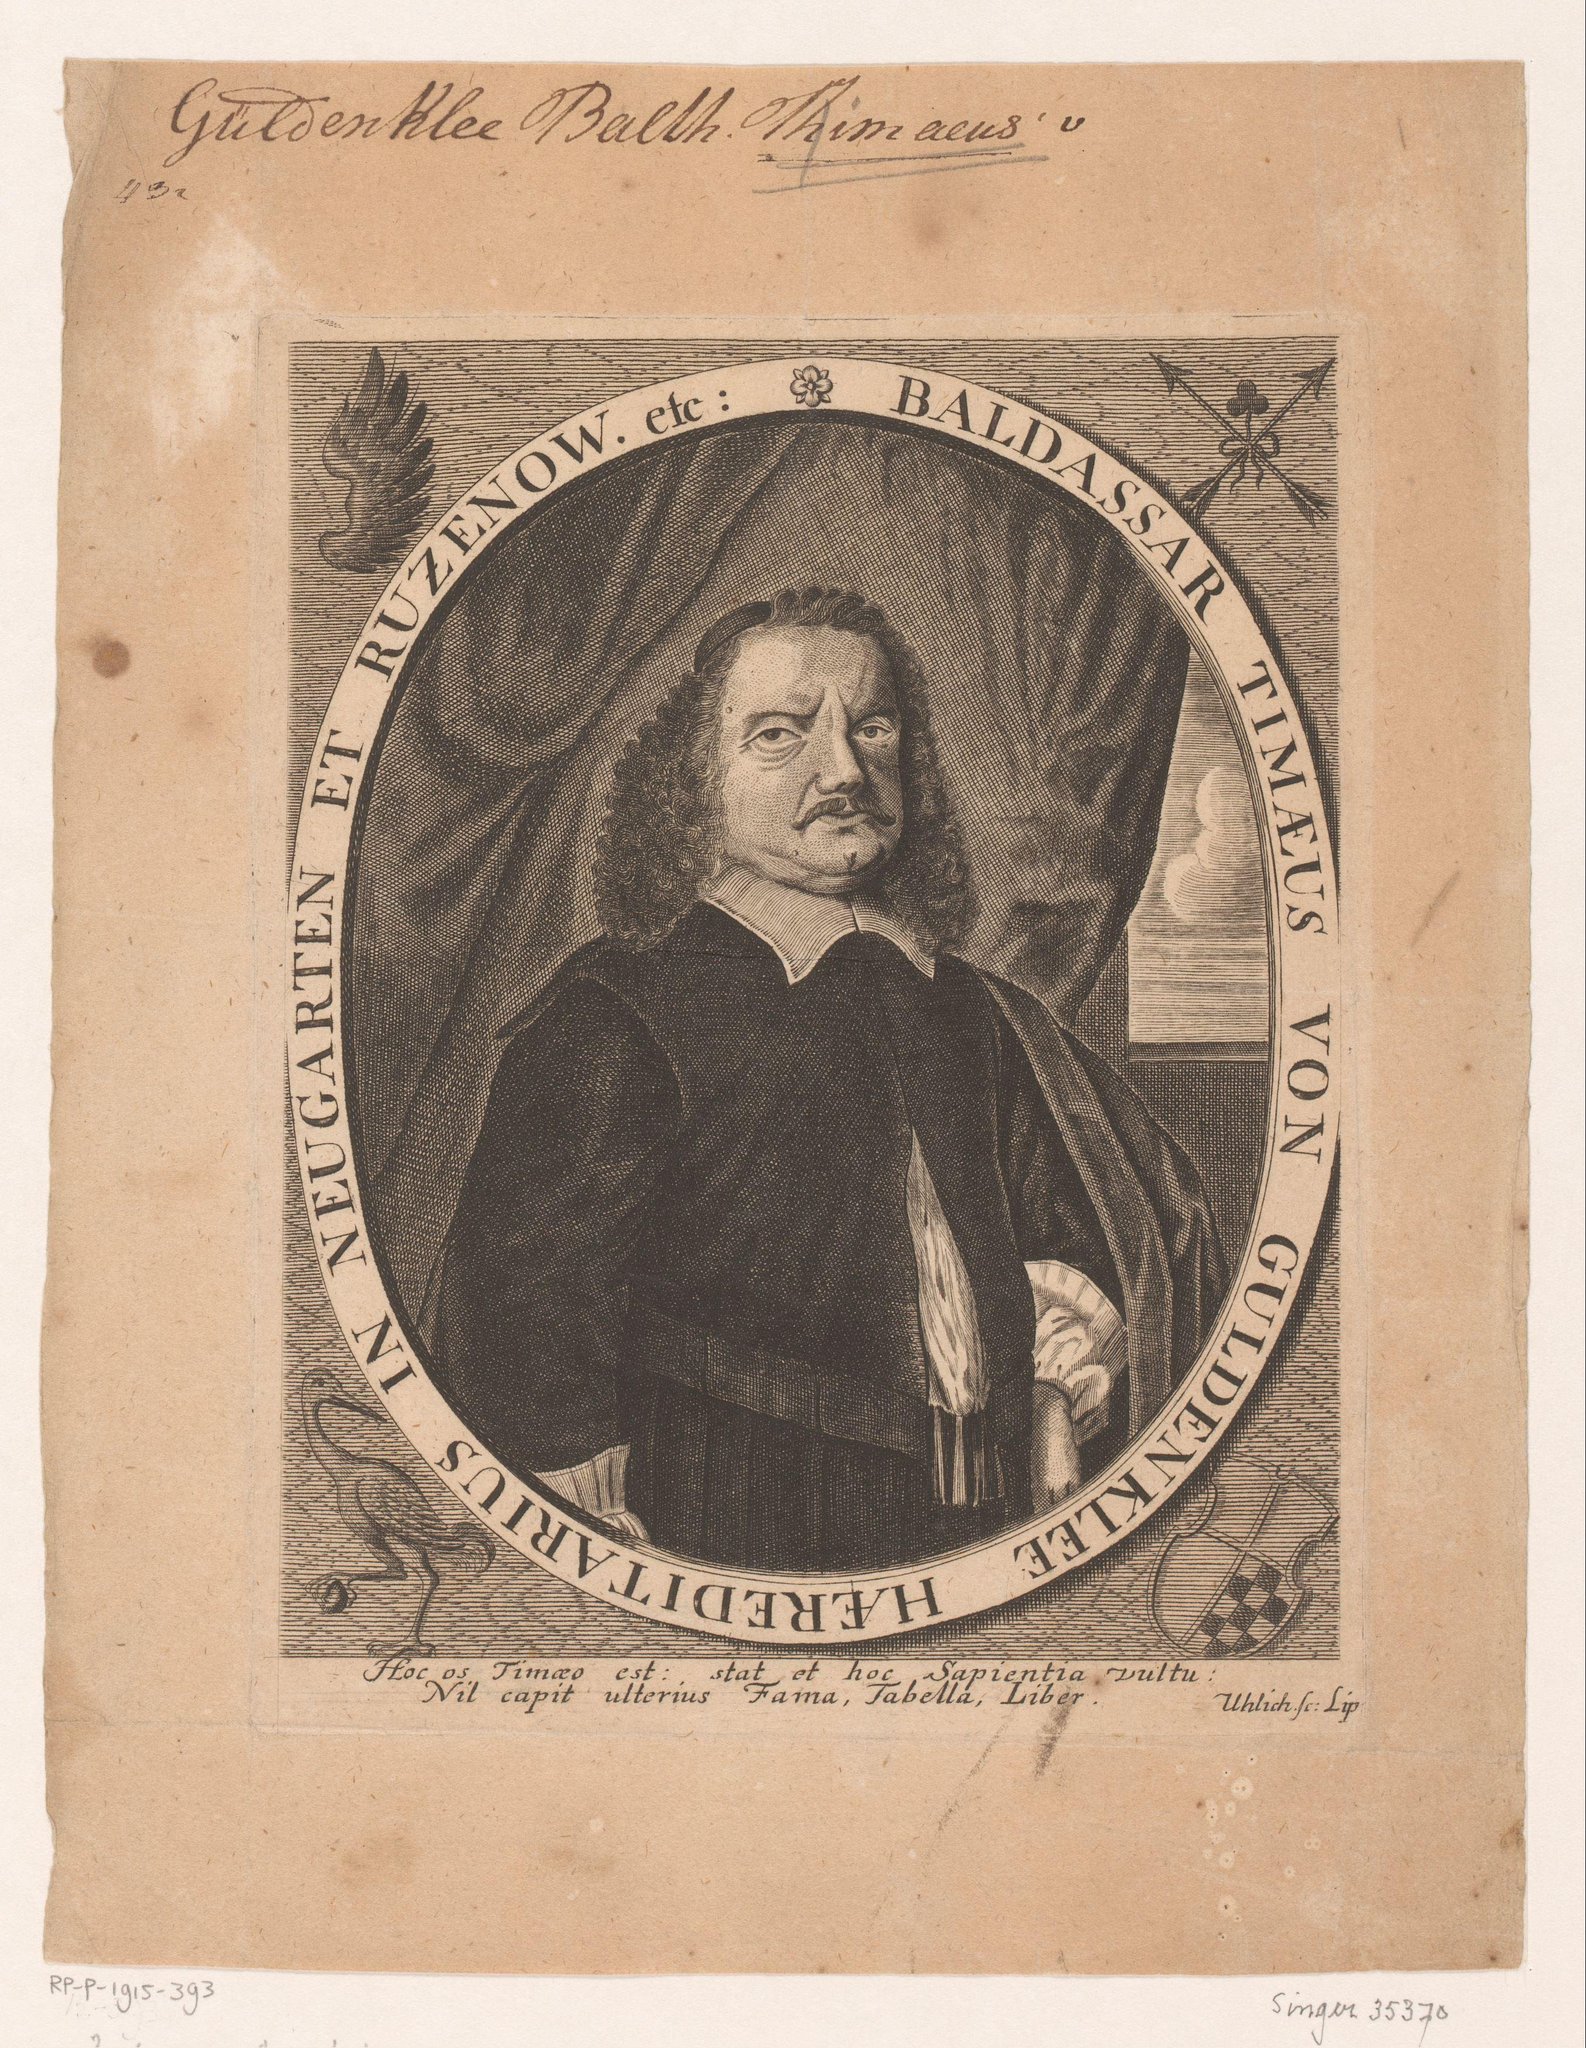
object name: print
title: Portret van Balthasar Timaeus von Güldenklee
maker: gabriel uhlich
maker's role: print maker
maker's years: 1682-1741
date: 1692-1741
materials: paper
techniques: engraving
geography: leipzig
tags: historical persons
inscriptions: collector's mark: Lugt 2228